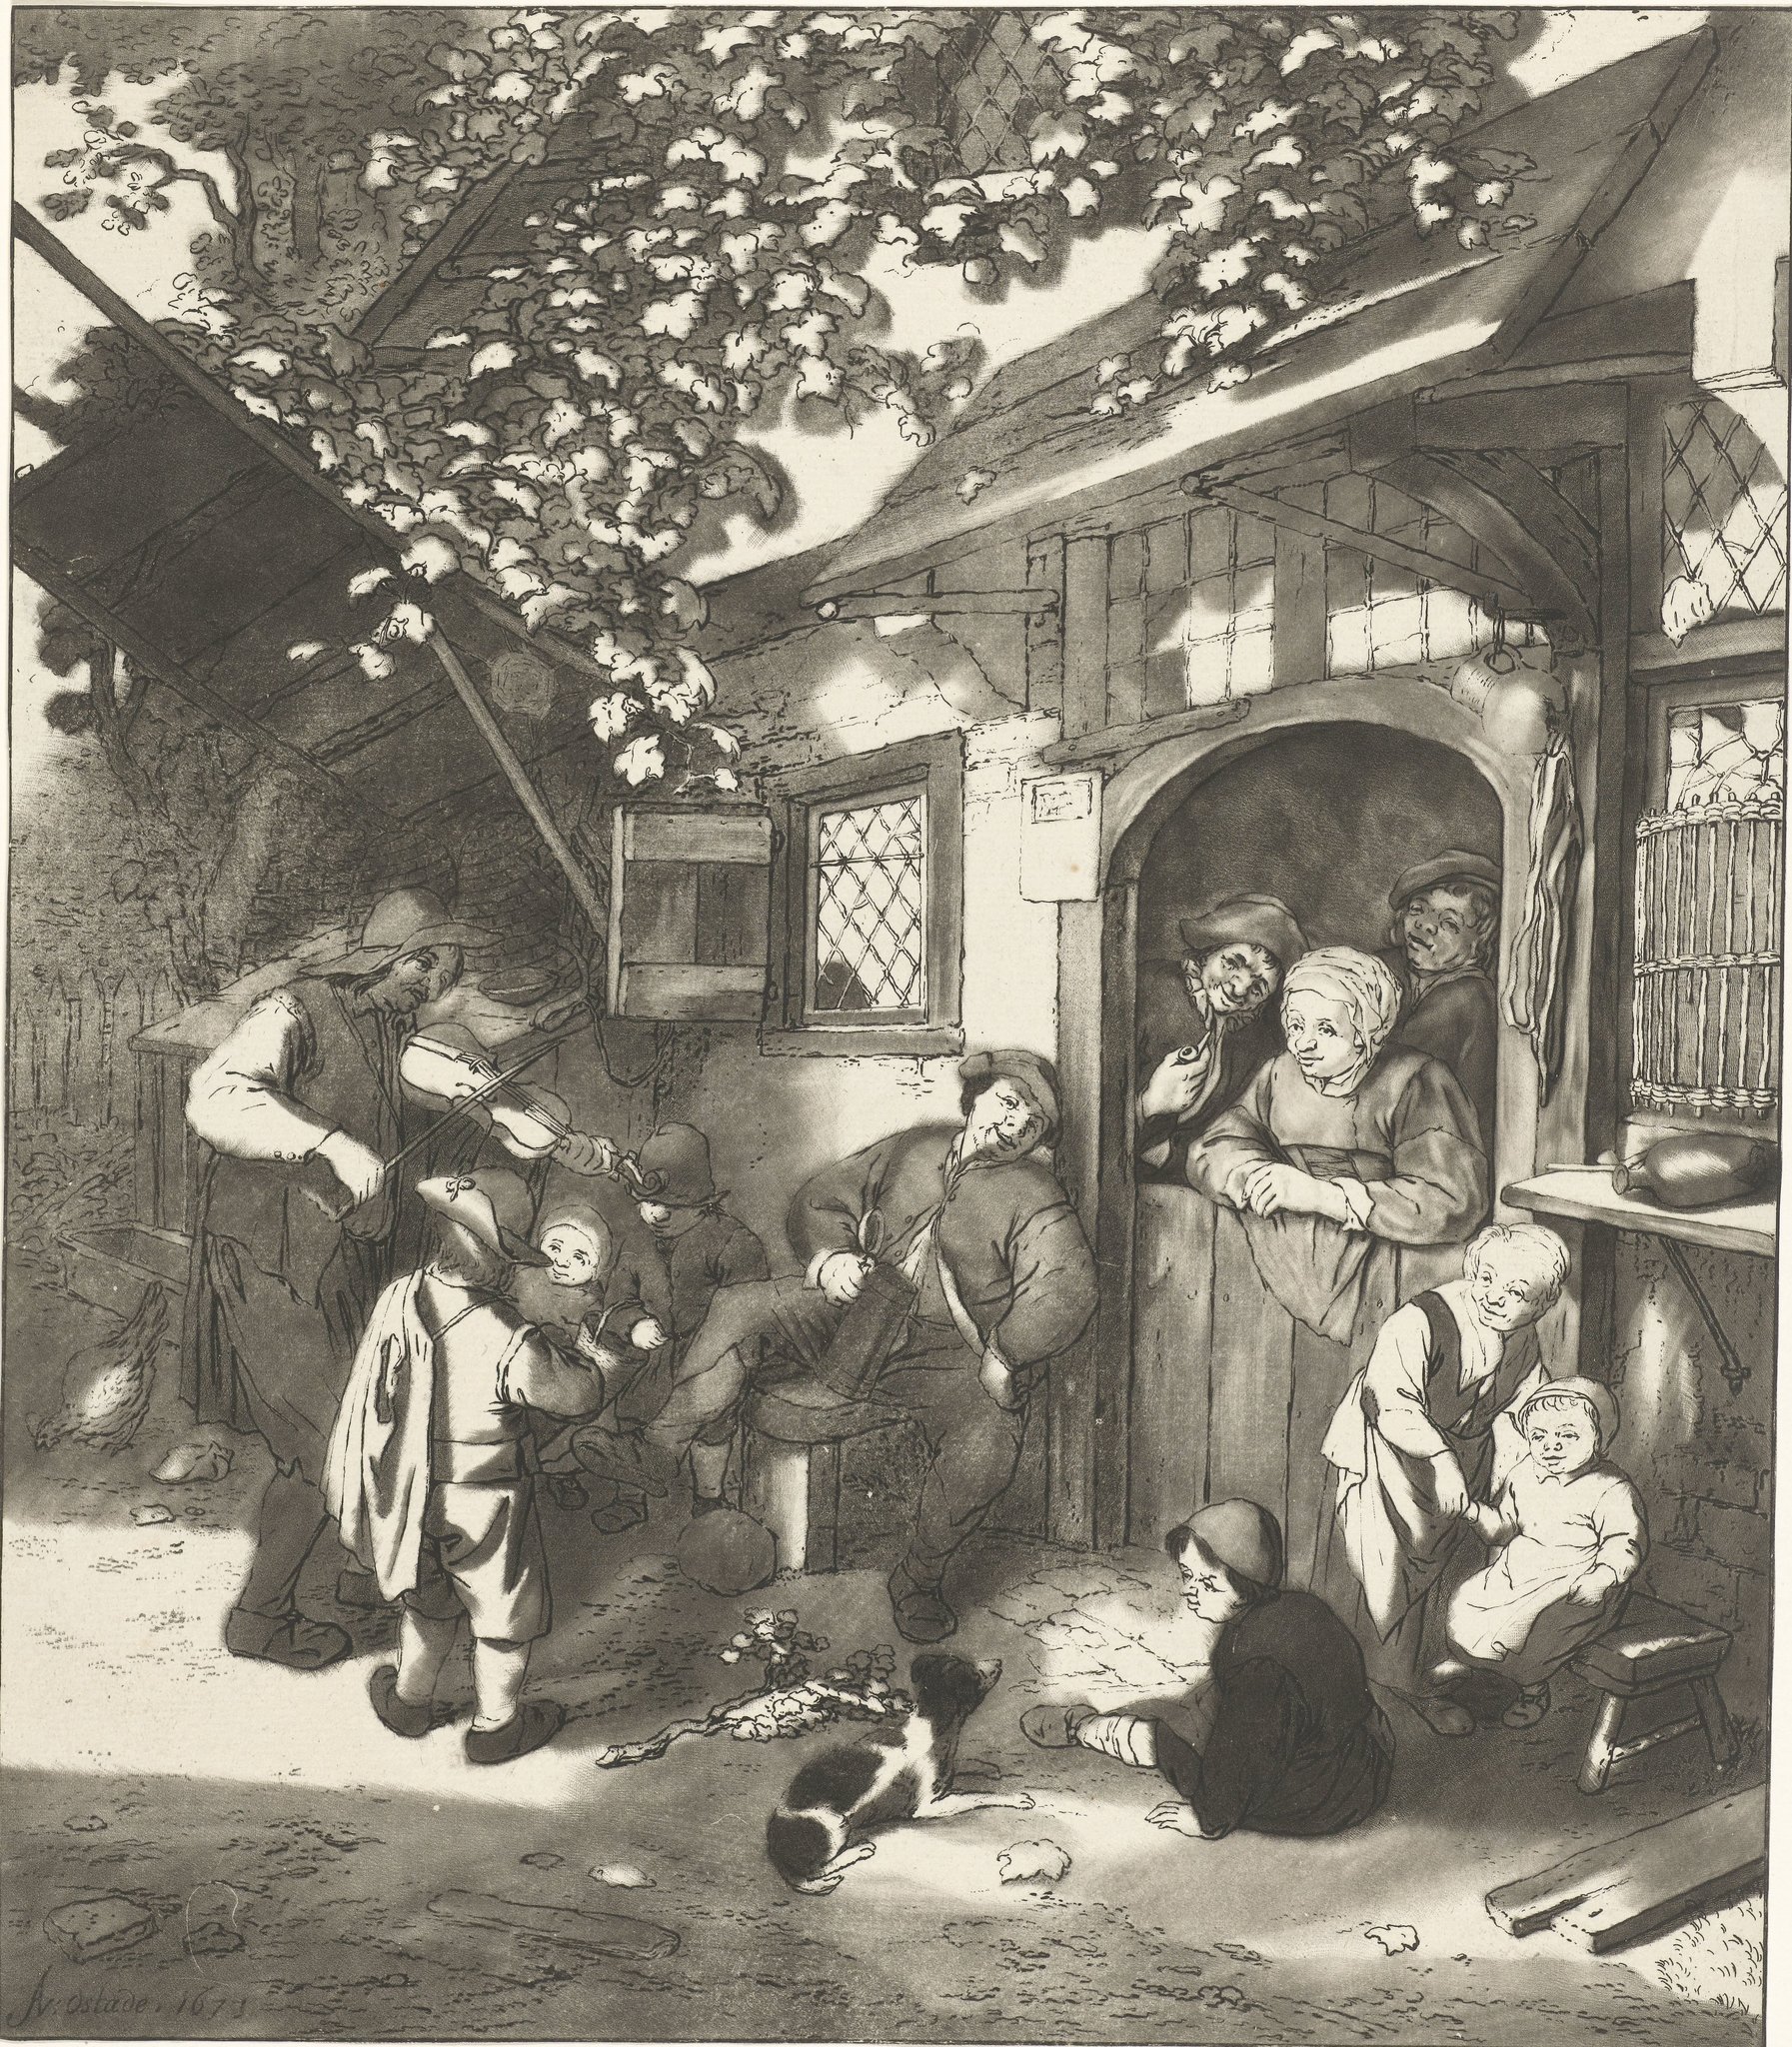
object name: print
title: Vioolspeler voor een herberg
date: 1766-1770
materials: paper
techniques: etching, roulette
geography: amsterdam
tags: one person playing string instrument (bowed), inn, coffee-house, public house, etc., dog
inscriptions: collector's mark: Lugt 240, inscription: ‘1 proef geoffeerd aan E.G: agtbare burgem Witsen PvA / P v Amstel f’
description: Een man met viool en een jongen met draailier maken muziek bij een herberg. Volwassenen en kinderen luisteren. Een vrouw leunt over de onderdeur.